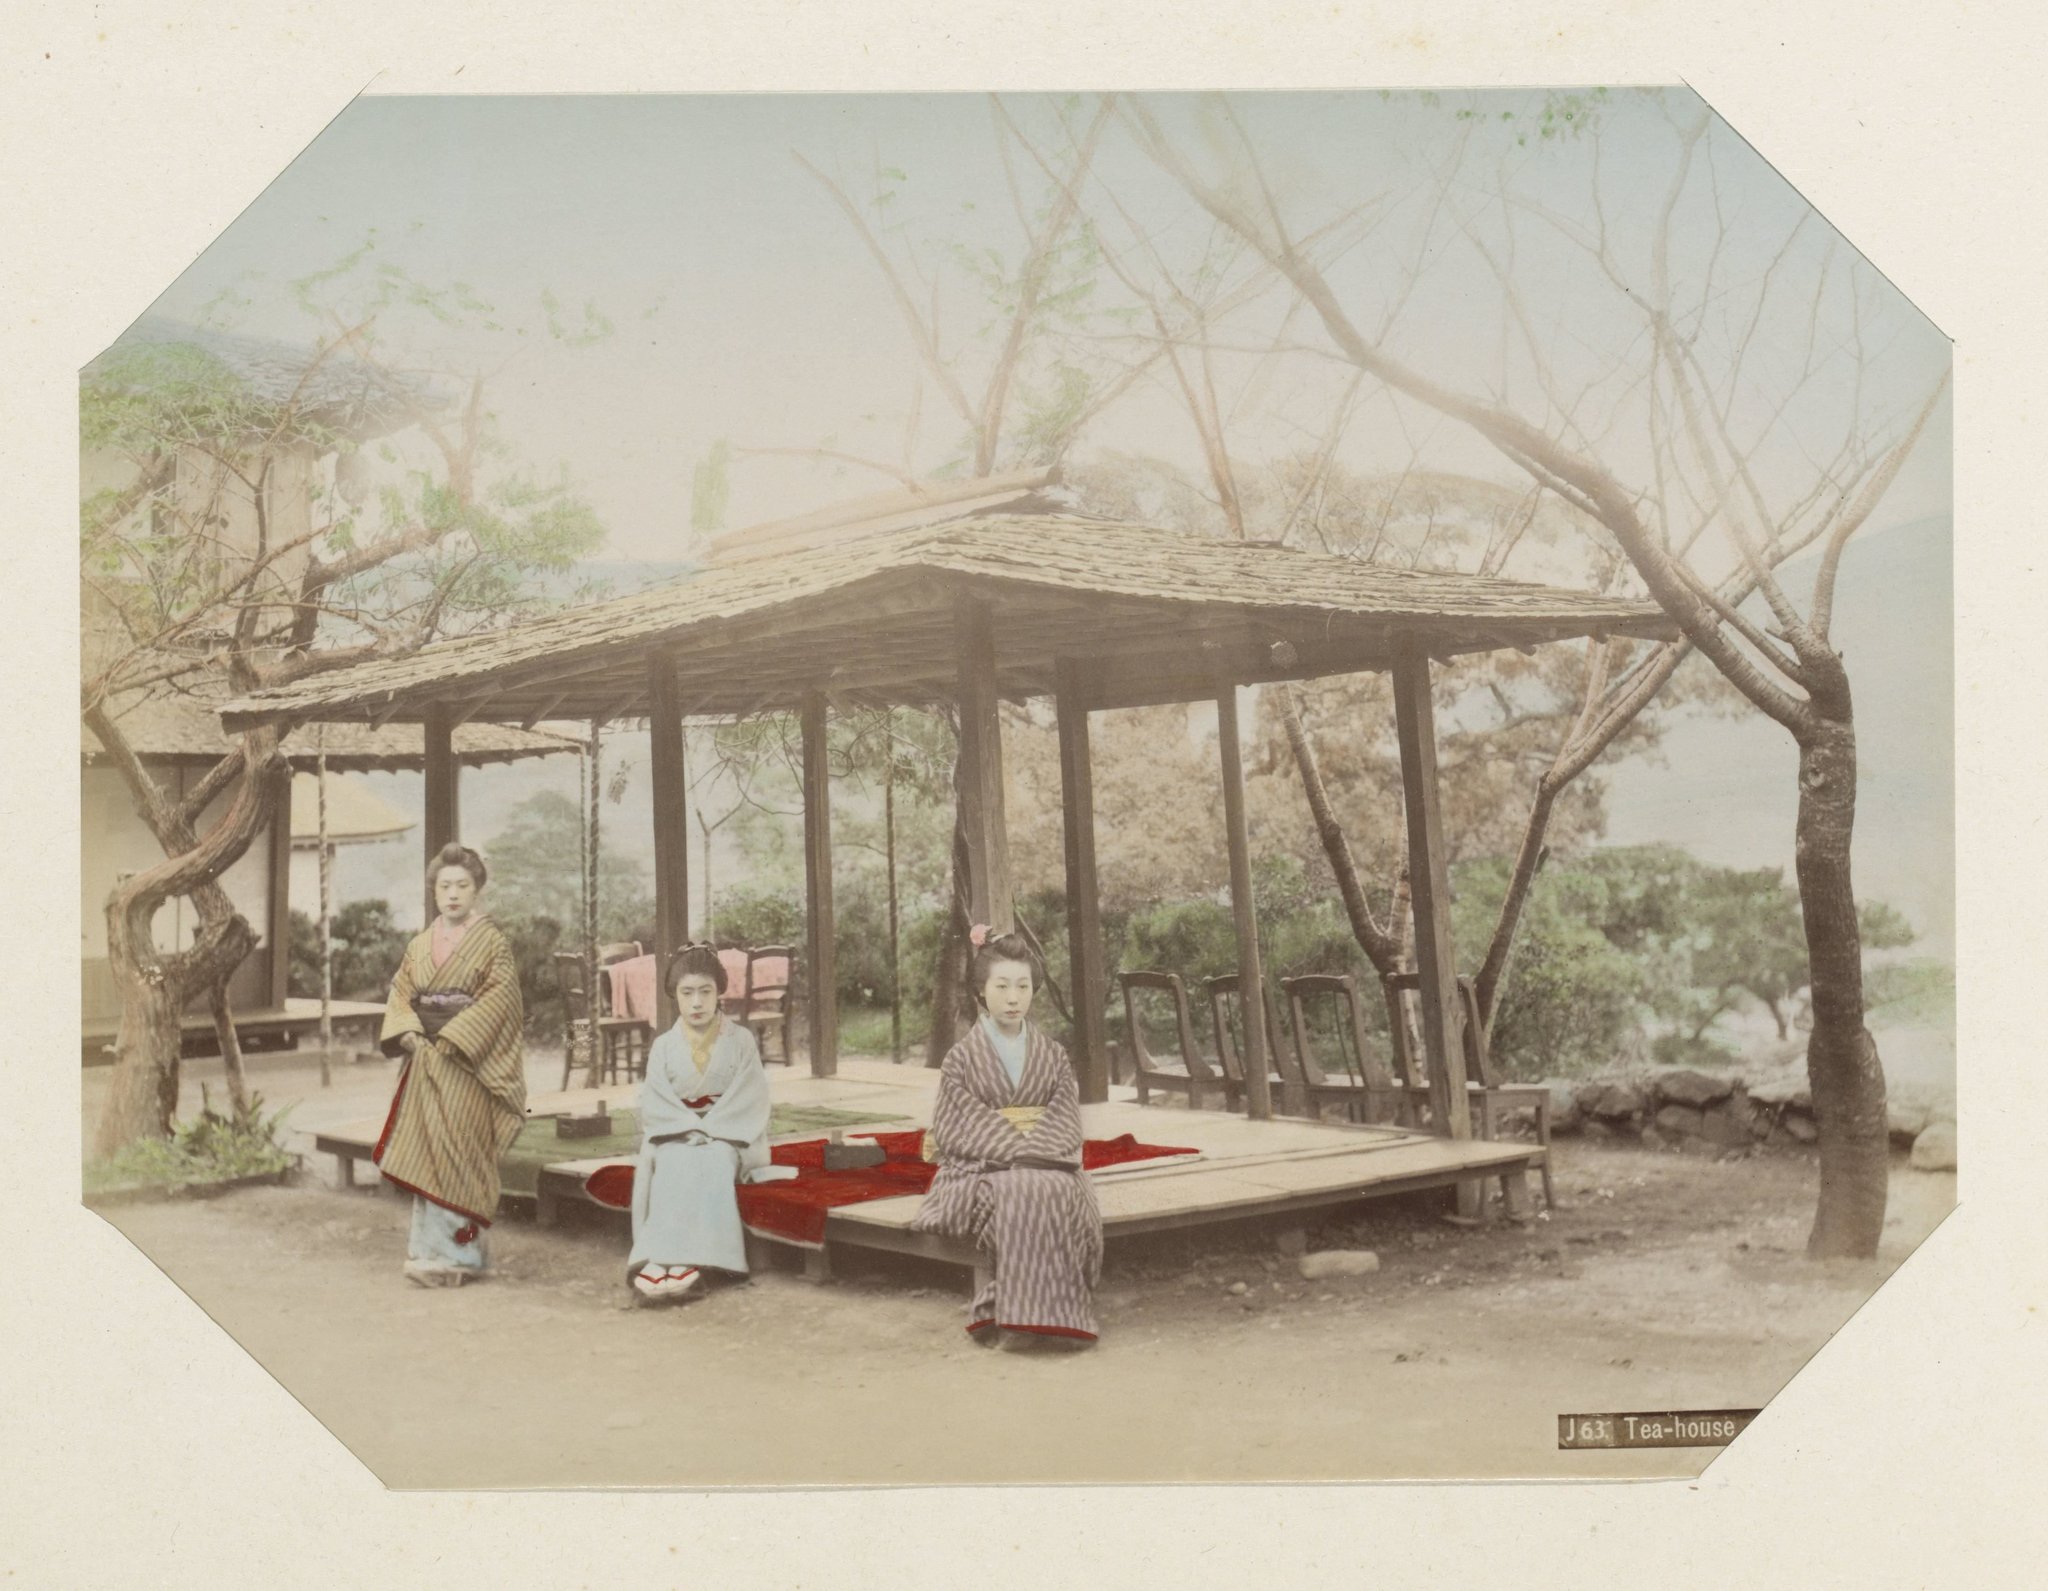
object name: photograph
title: Tea-house at suwa park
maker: Anonymous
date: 1870-1900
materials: paint, photographic support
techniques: albumen print, hand coloring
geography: omuta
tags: folk costume, regional costume (+ women's clothes), adult woman, public gardens, park (+ city(-scape) with figures, staffage)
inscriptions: number: ‘J 63’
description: Onderdeel van Fotoalbum met opnames van bezienswaardigheden in Japan en studioportretten.